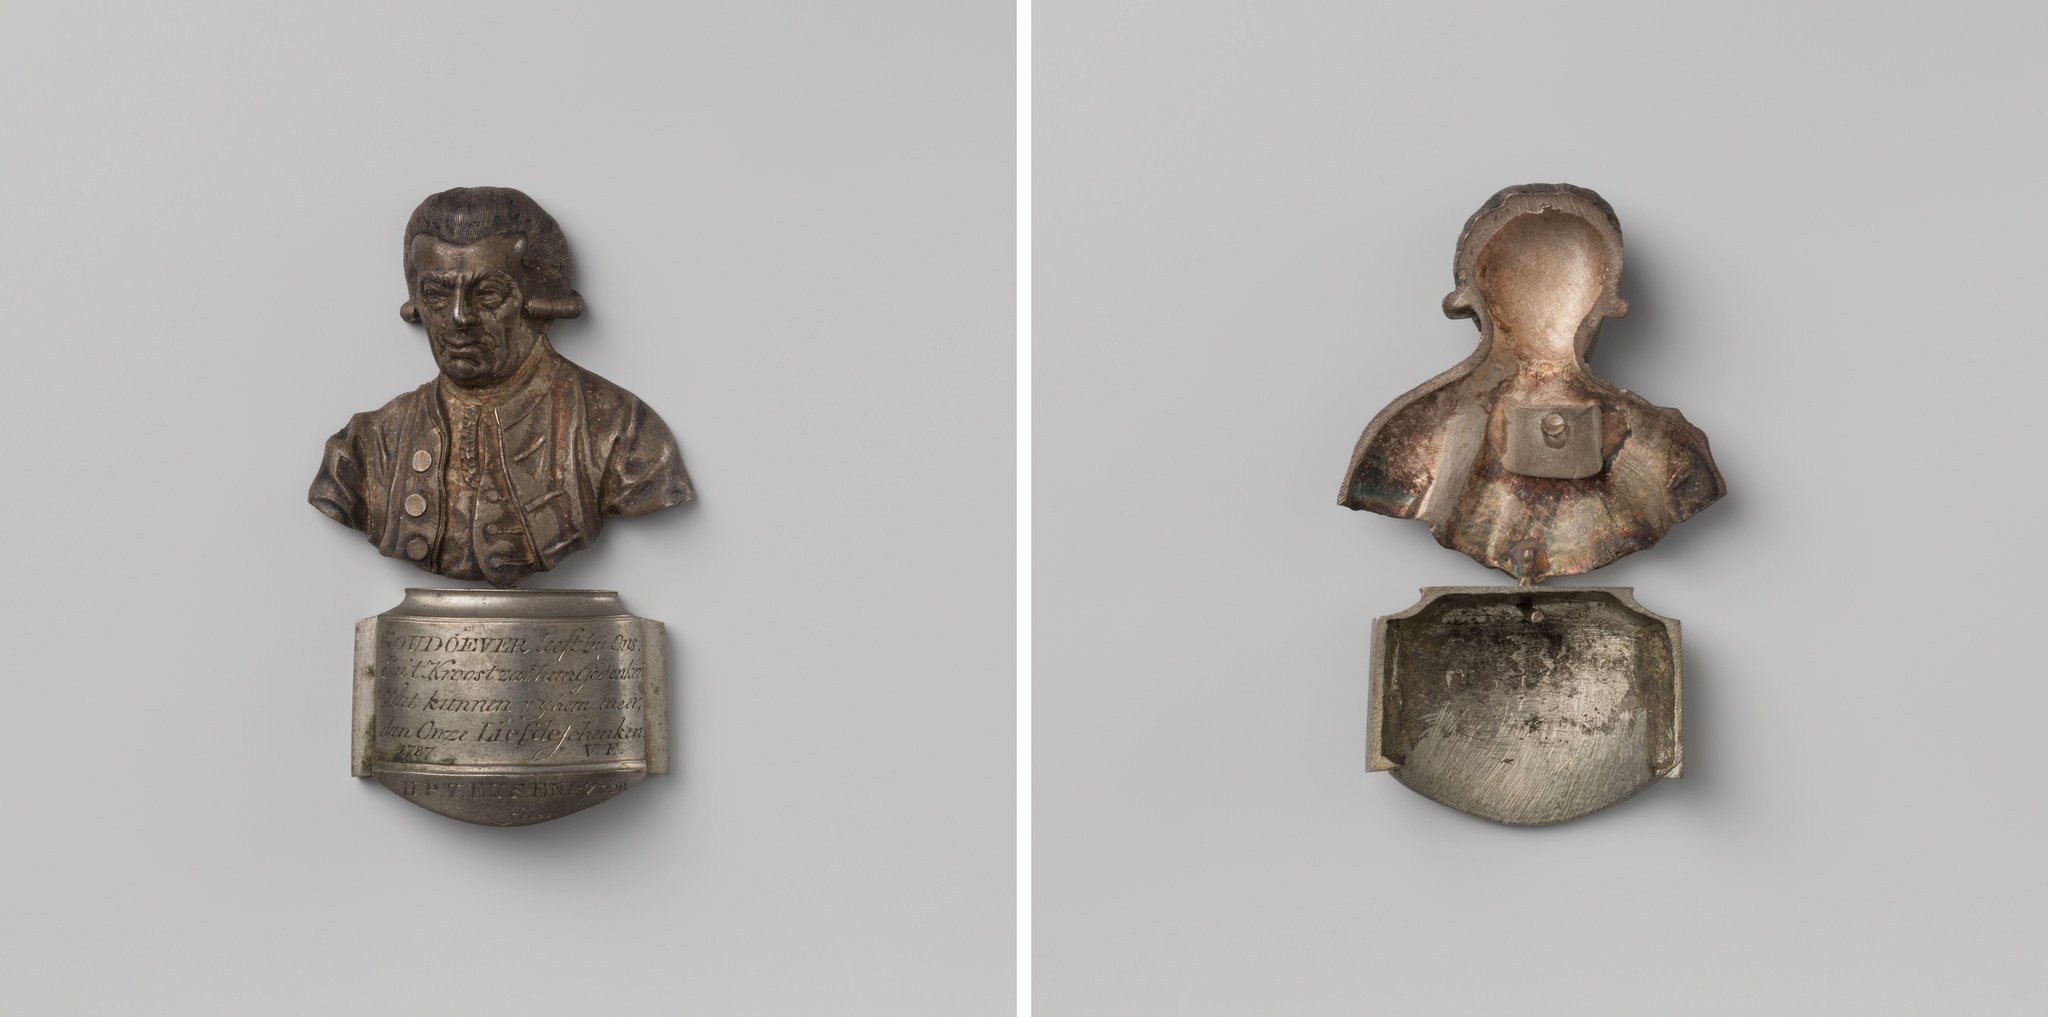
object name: plaque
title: Isaac van Goudoever, kolonel van het Witte regiment van de schutterij op de Dam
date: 1787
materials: silver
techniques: engraving, screwed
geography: amsterdam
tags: amsterdam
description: eenzijdige plaquette in hoogrelief, bestaande uit borststuk man met pin bevestigd op bol voetstuk met opschrift